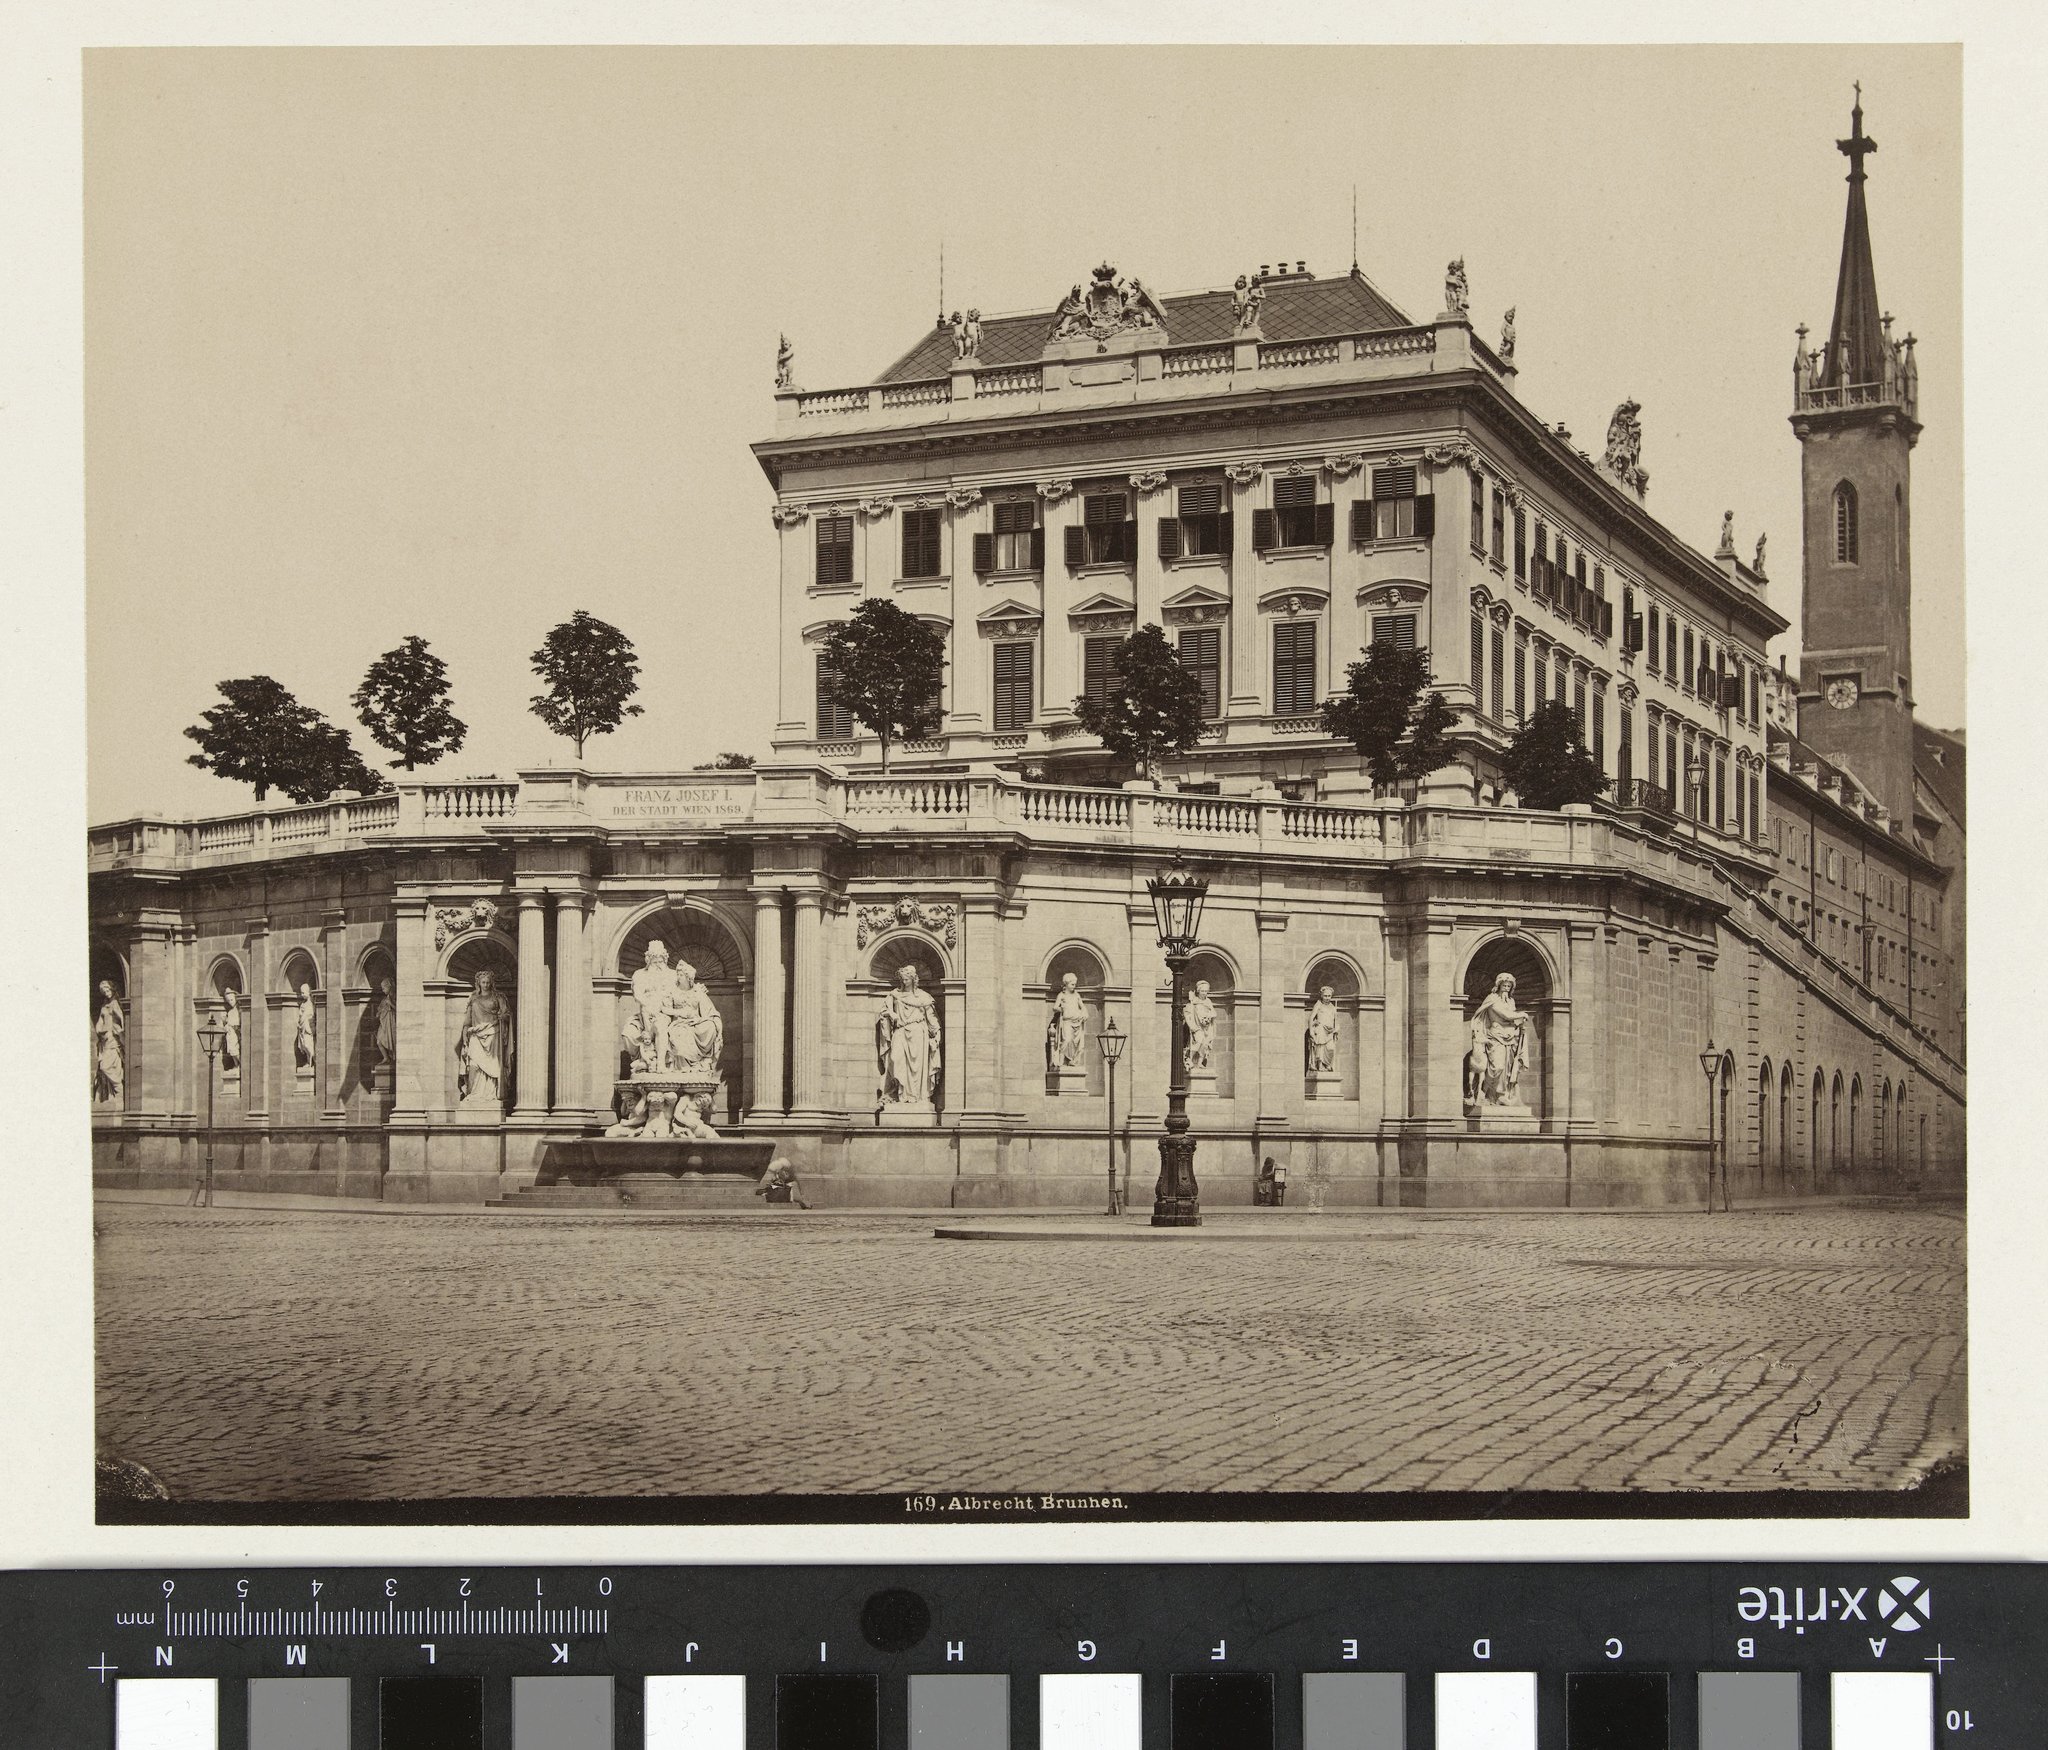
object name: photograph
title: Albrecht Brunnen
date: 1869-1900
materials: cardboard, paper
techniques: albumen print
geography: vienna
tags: ornamental fountain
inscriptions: number: ‘169.’